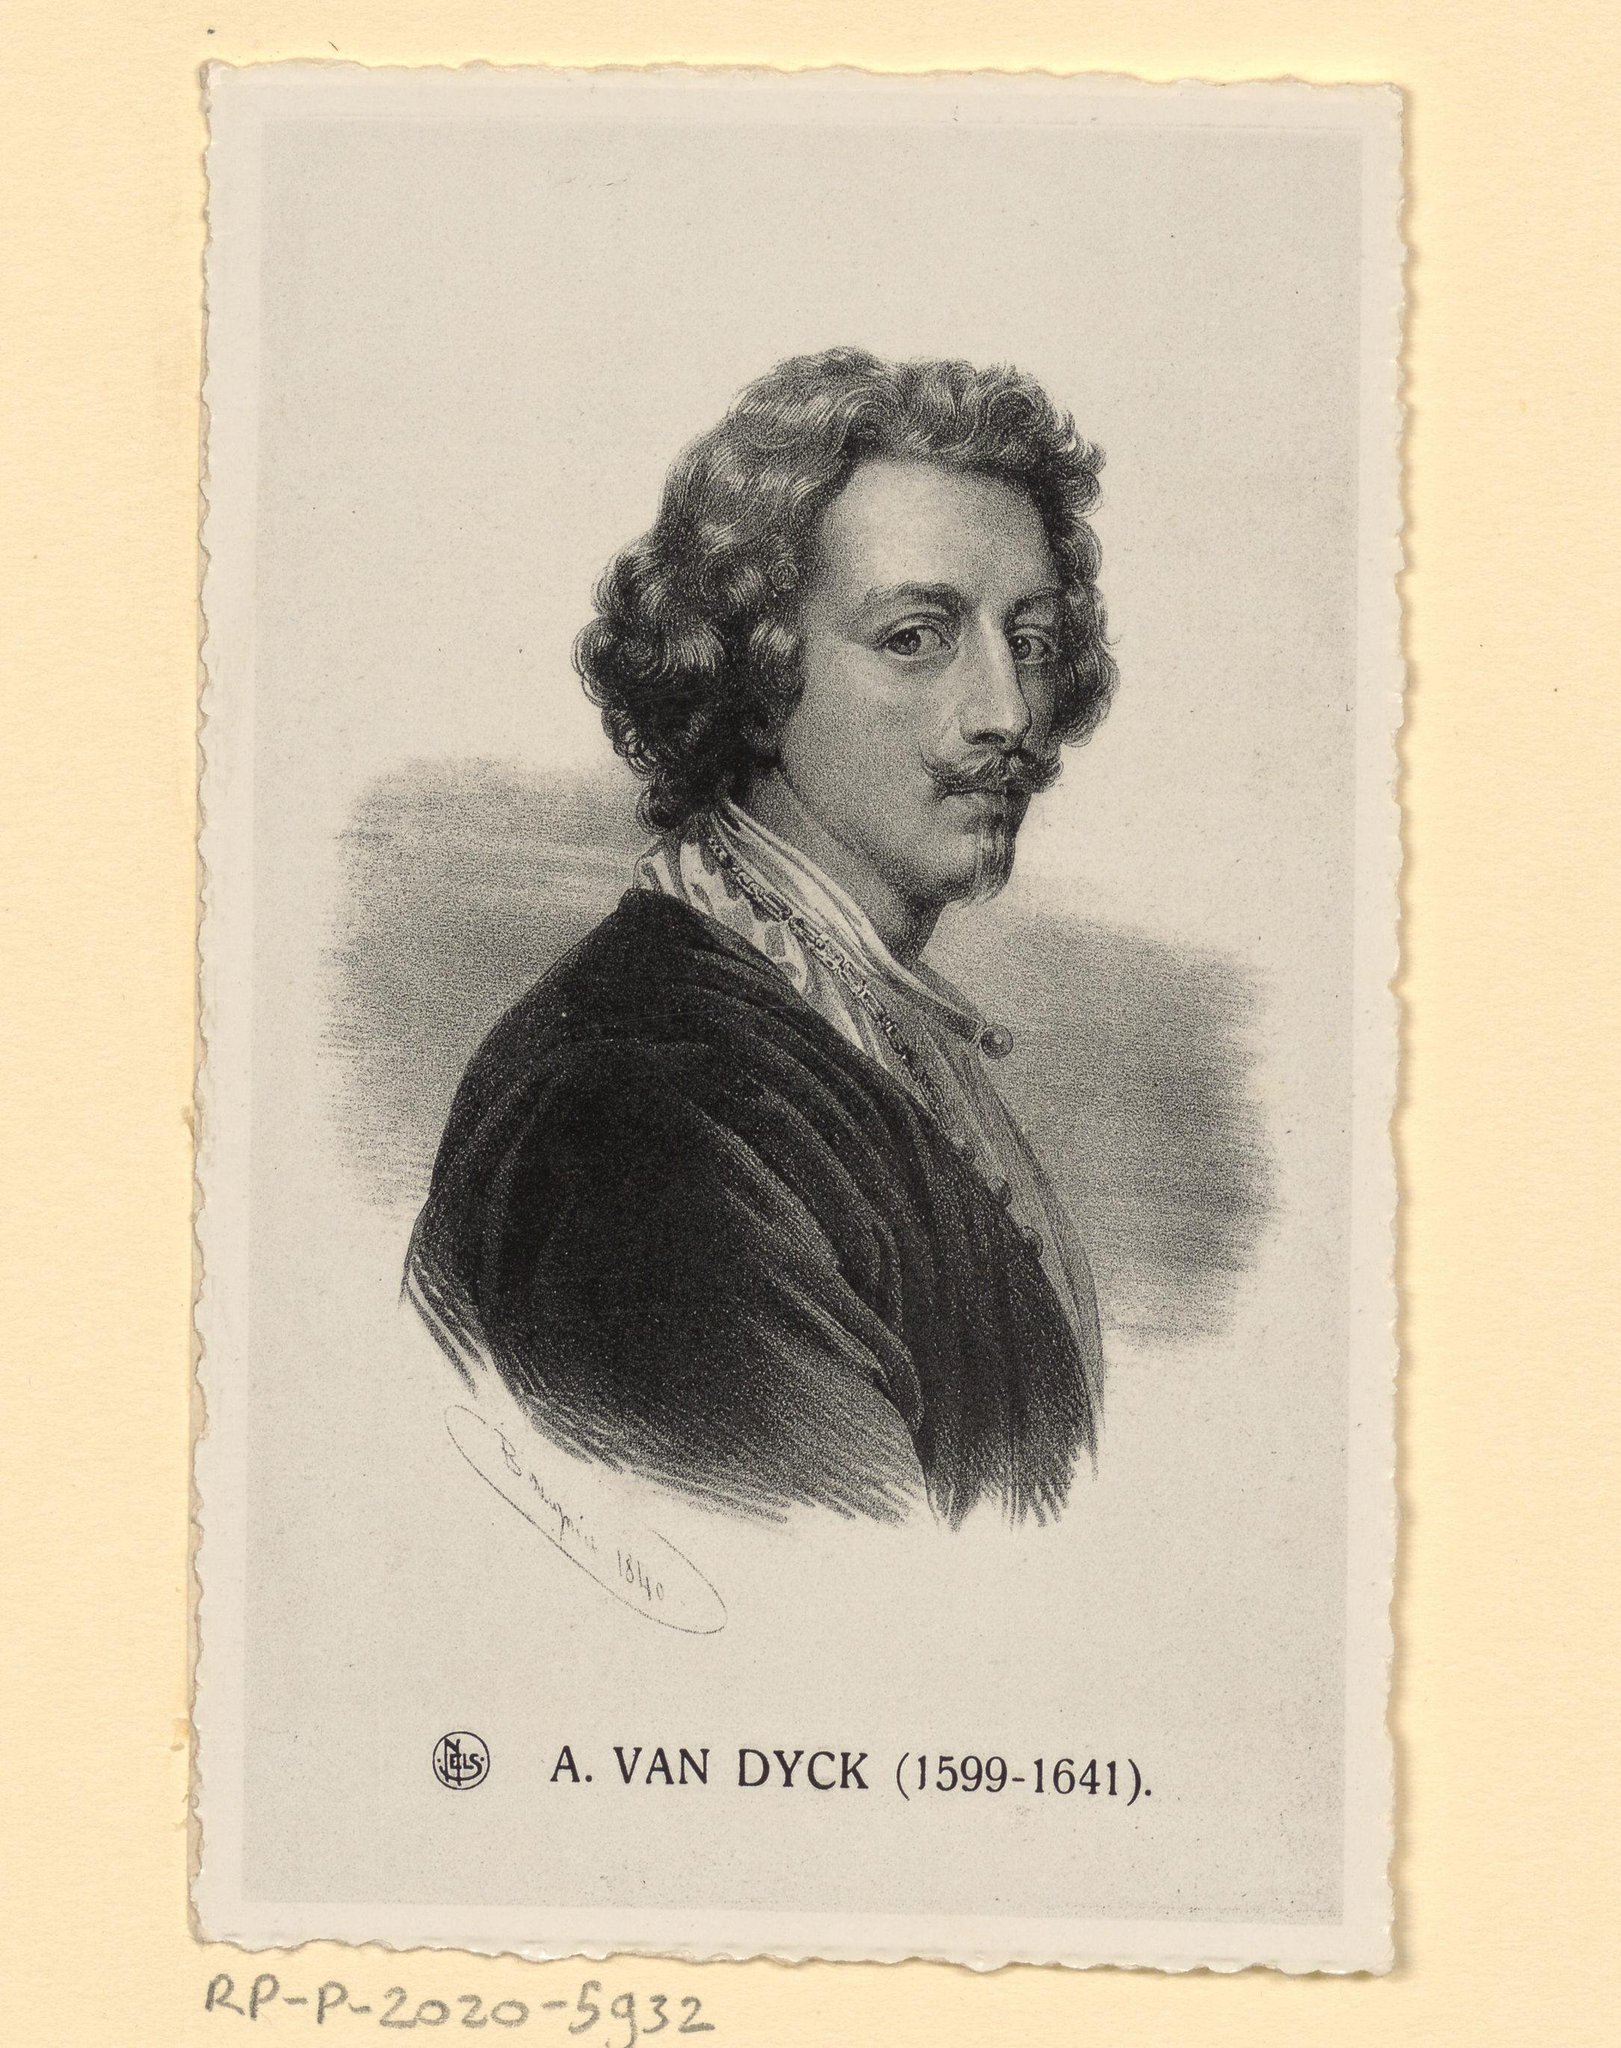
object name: photograph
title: A. van Dyck (1599-1641)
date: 1913-1950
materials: photographic support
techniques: photography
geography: brussels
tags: antwerp, london, painter, print maker, draughtsman, anthony van dyck, historical persons, portrait, self-portrait of painter